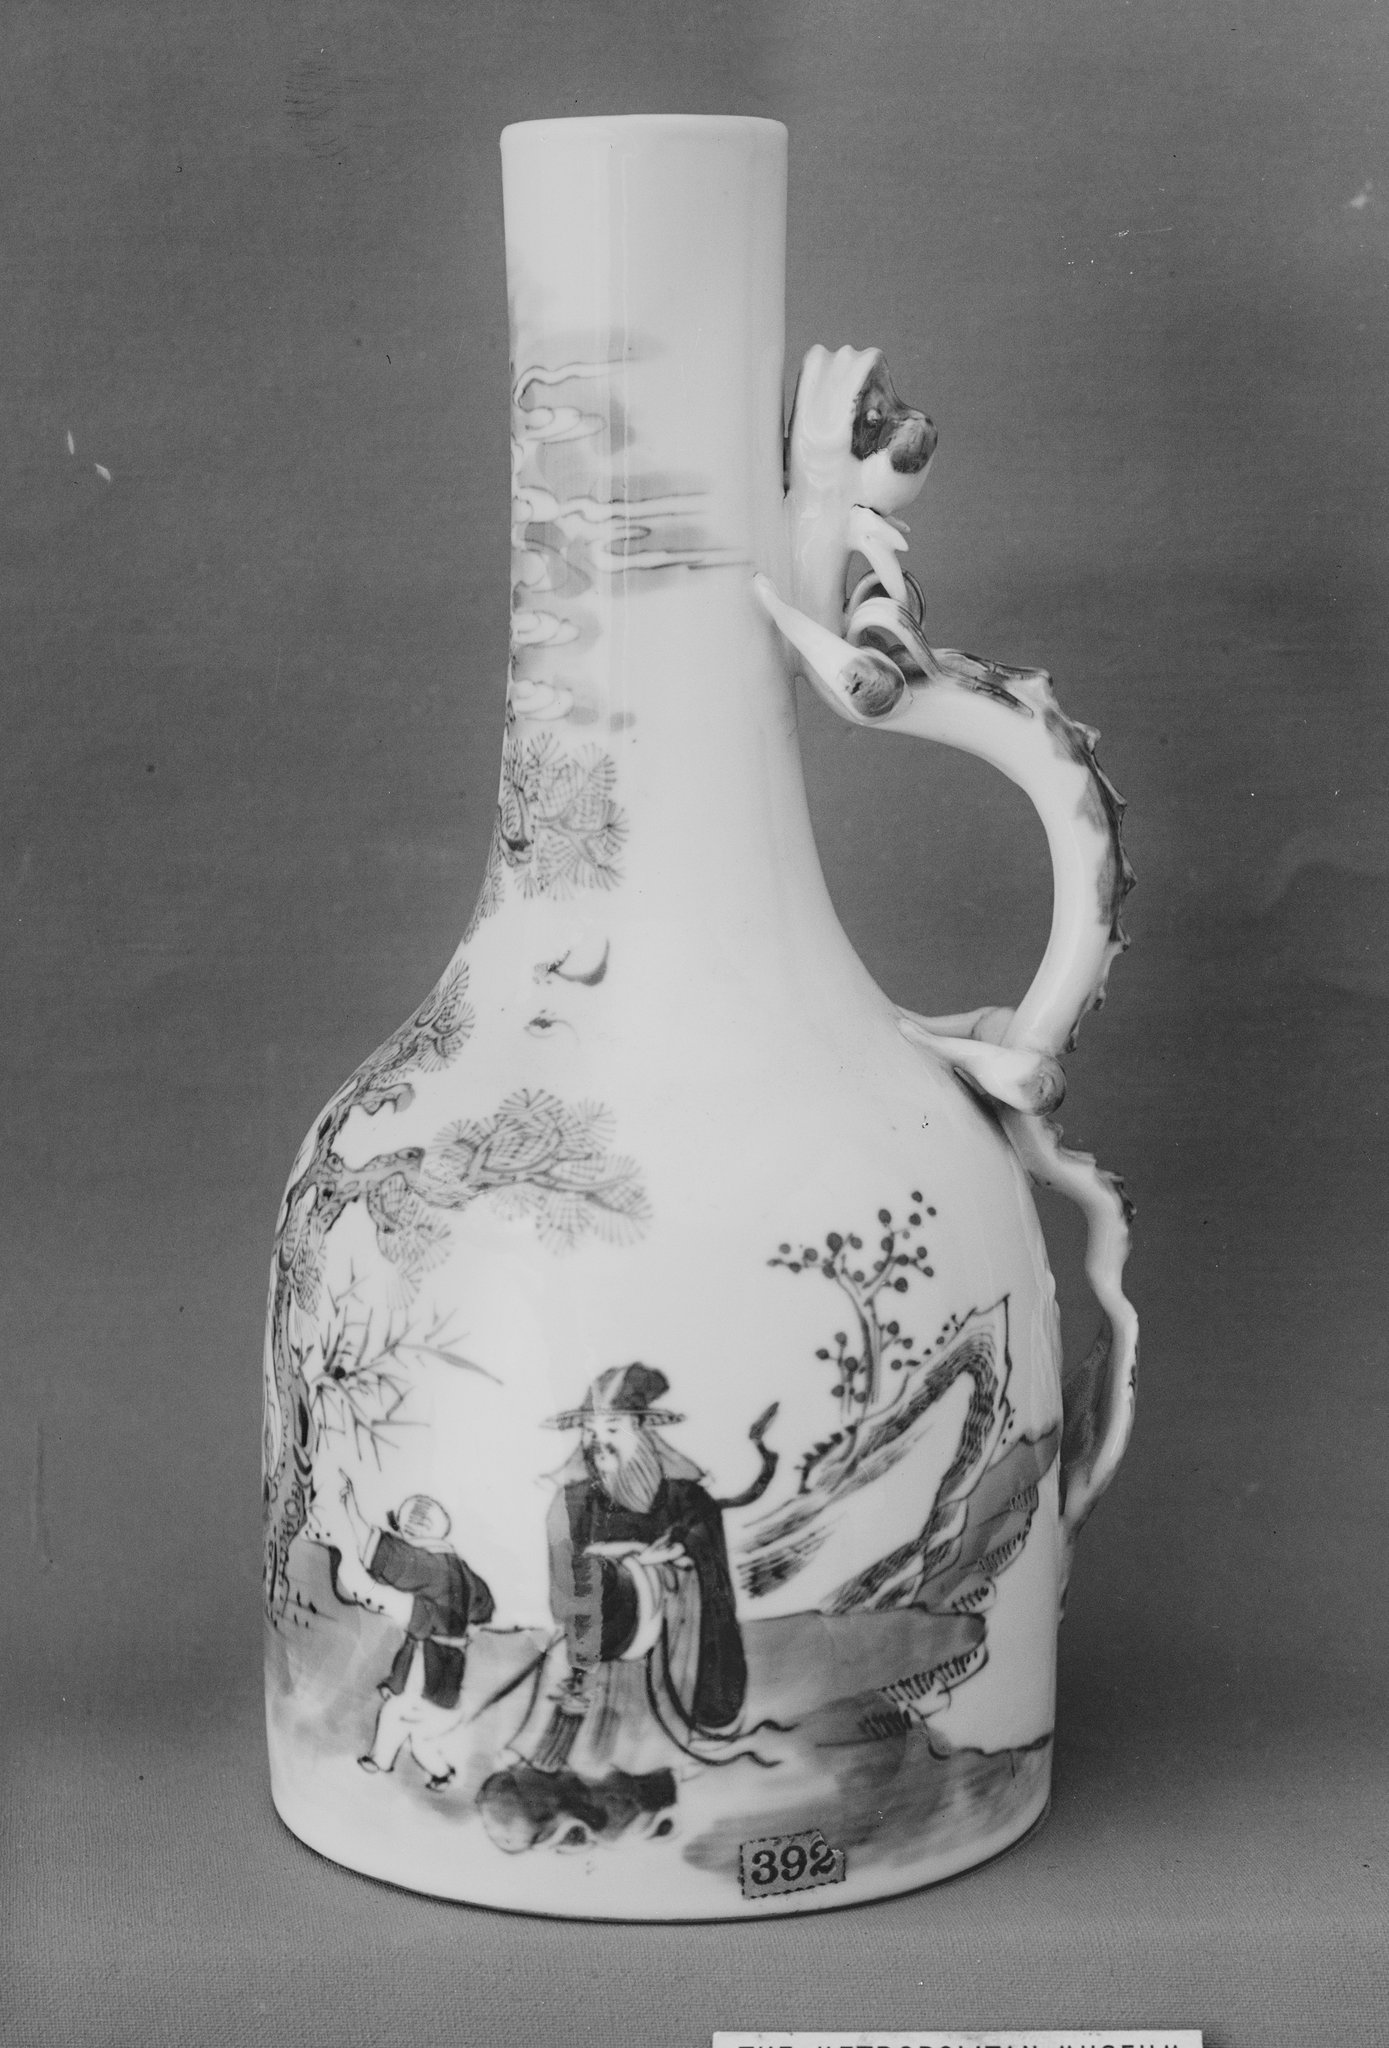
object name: bottle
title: Bottle with One Handle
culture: japanese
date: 1701-1800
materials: glaze, porcelain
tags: men,trees